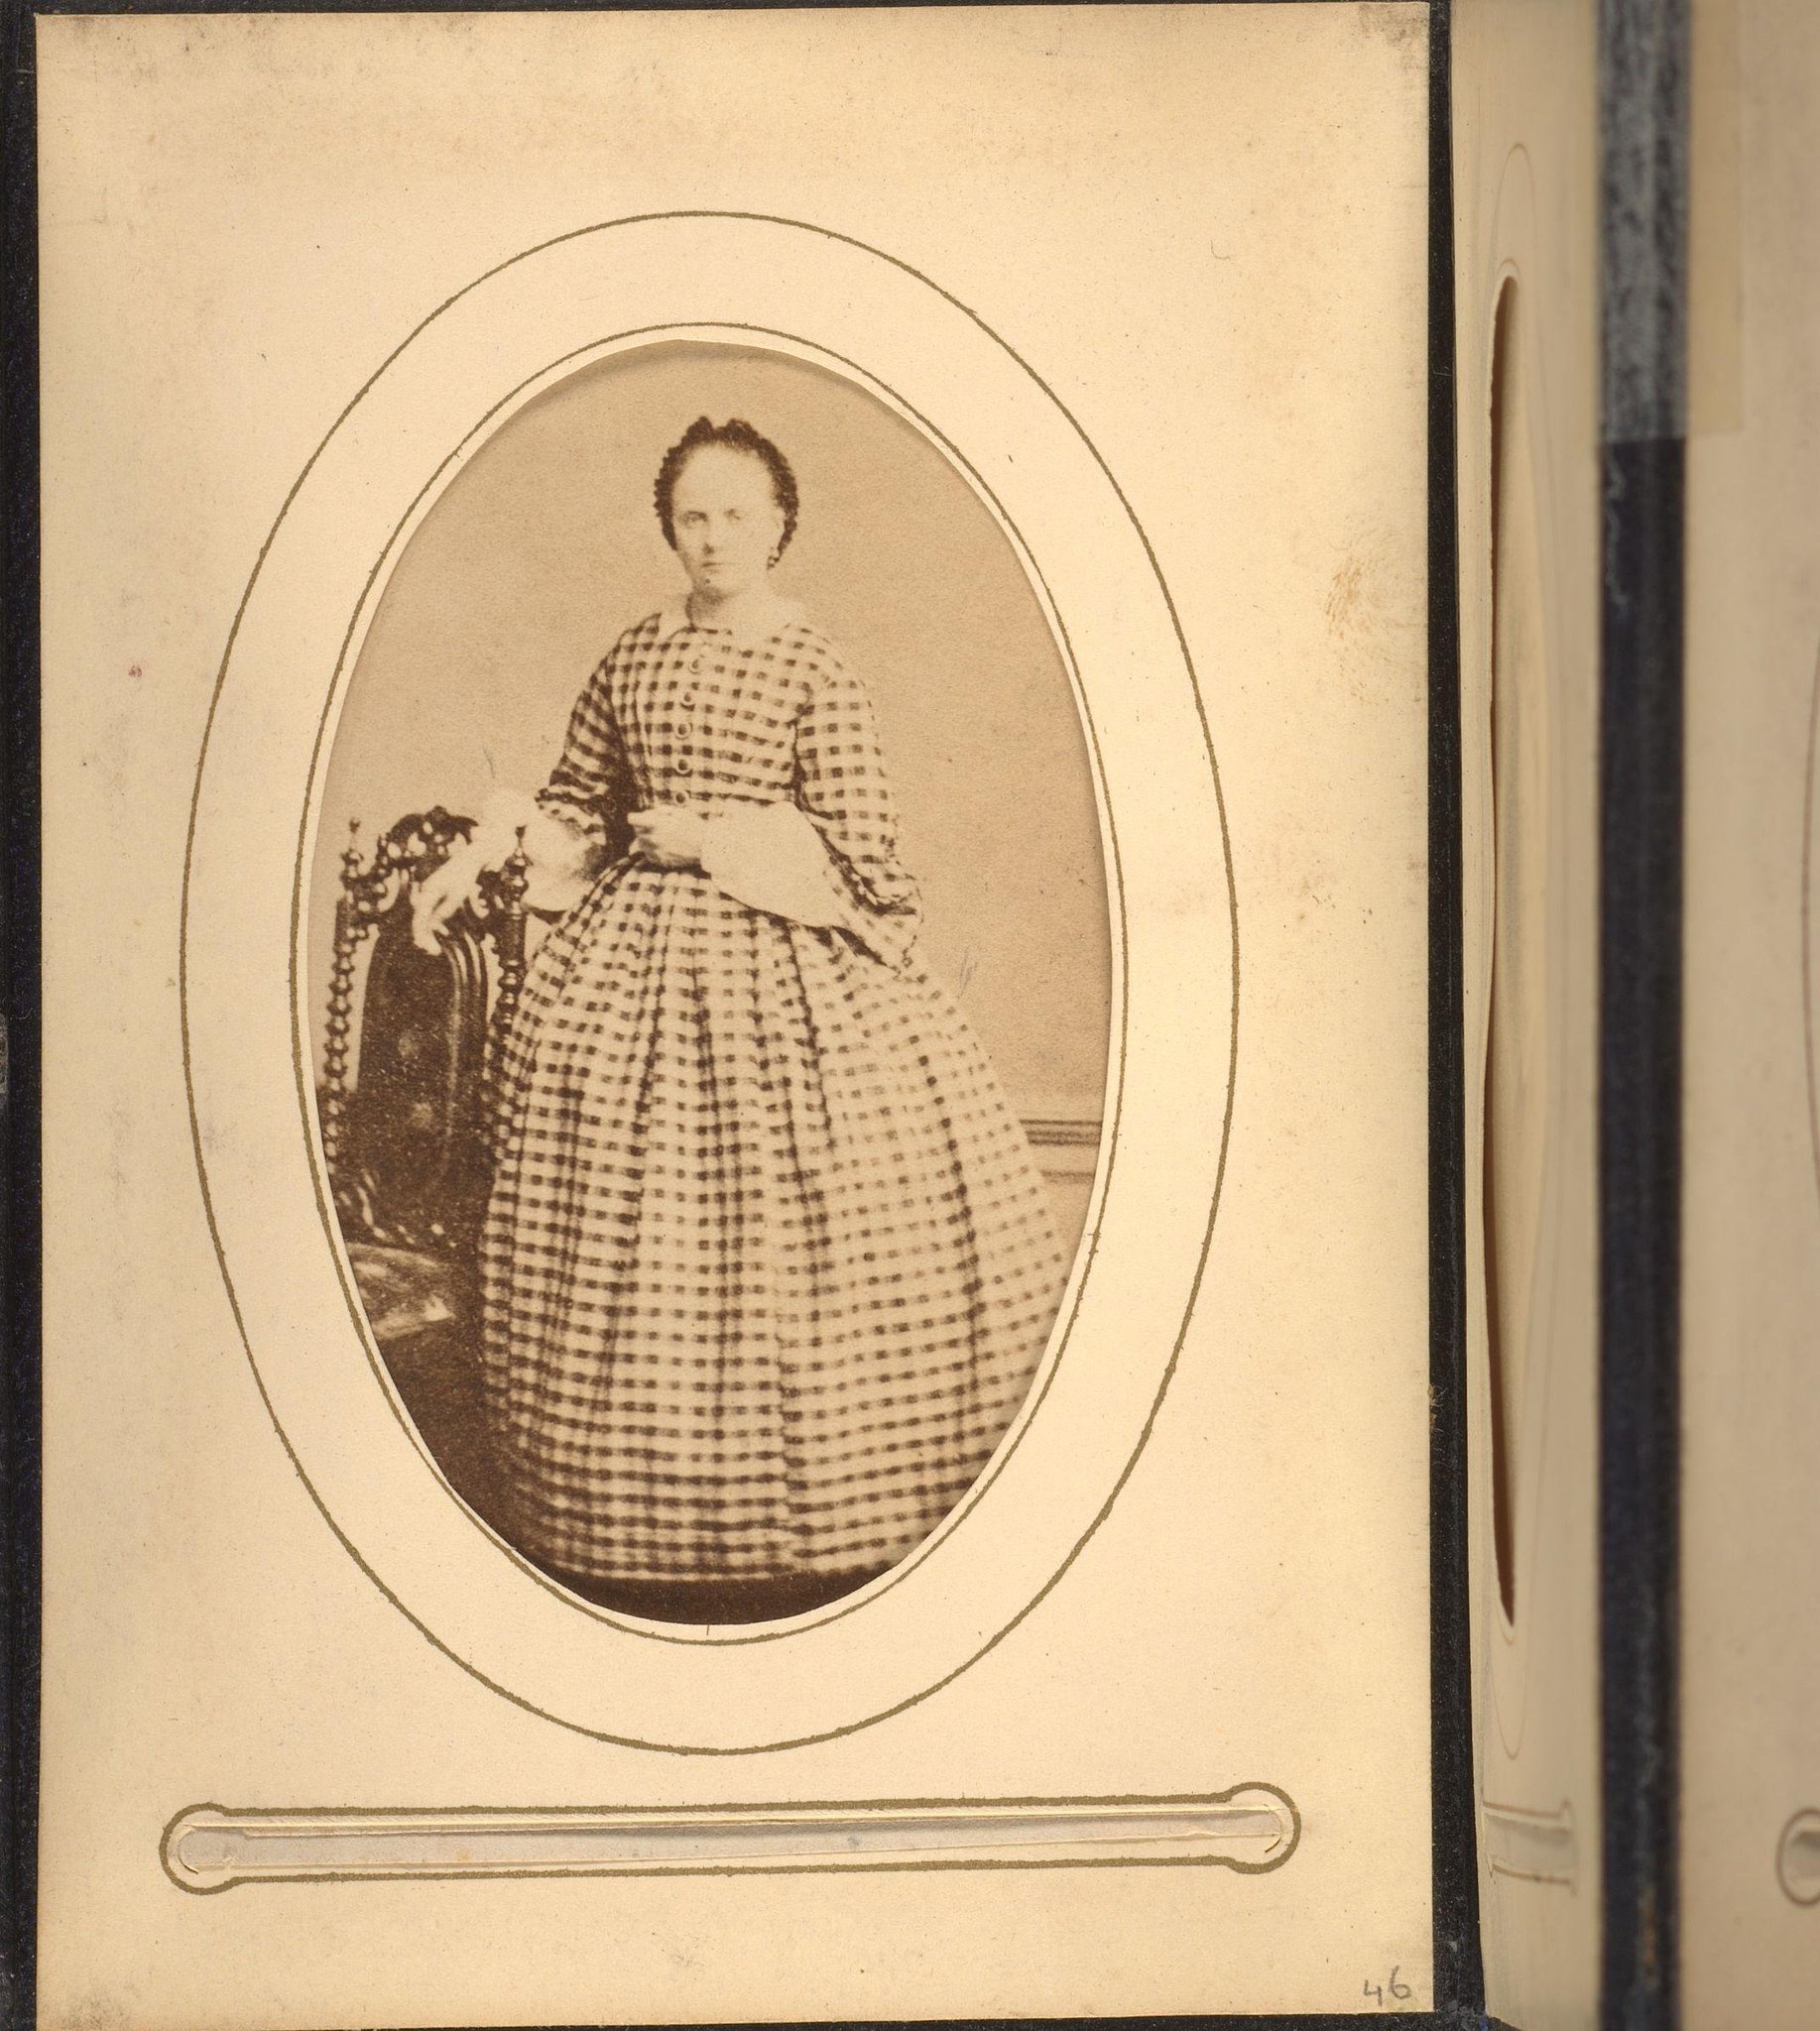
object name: photograph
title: Portret van een vrouw in geruite jurk, staand bij een stoel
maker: Anonymous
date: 1860-1900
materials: cardboard, photographic support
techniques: albumen print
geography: netherlands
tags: historical persons - bb - woman, standing figure - aa - female human figure, chair